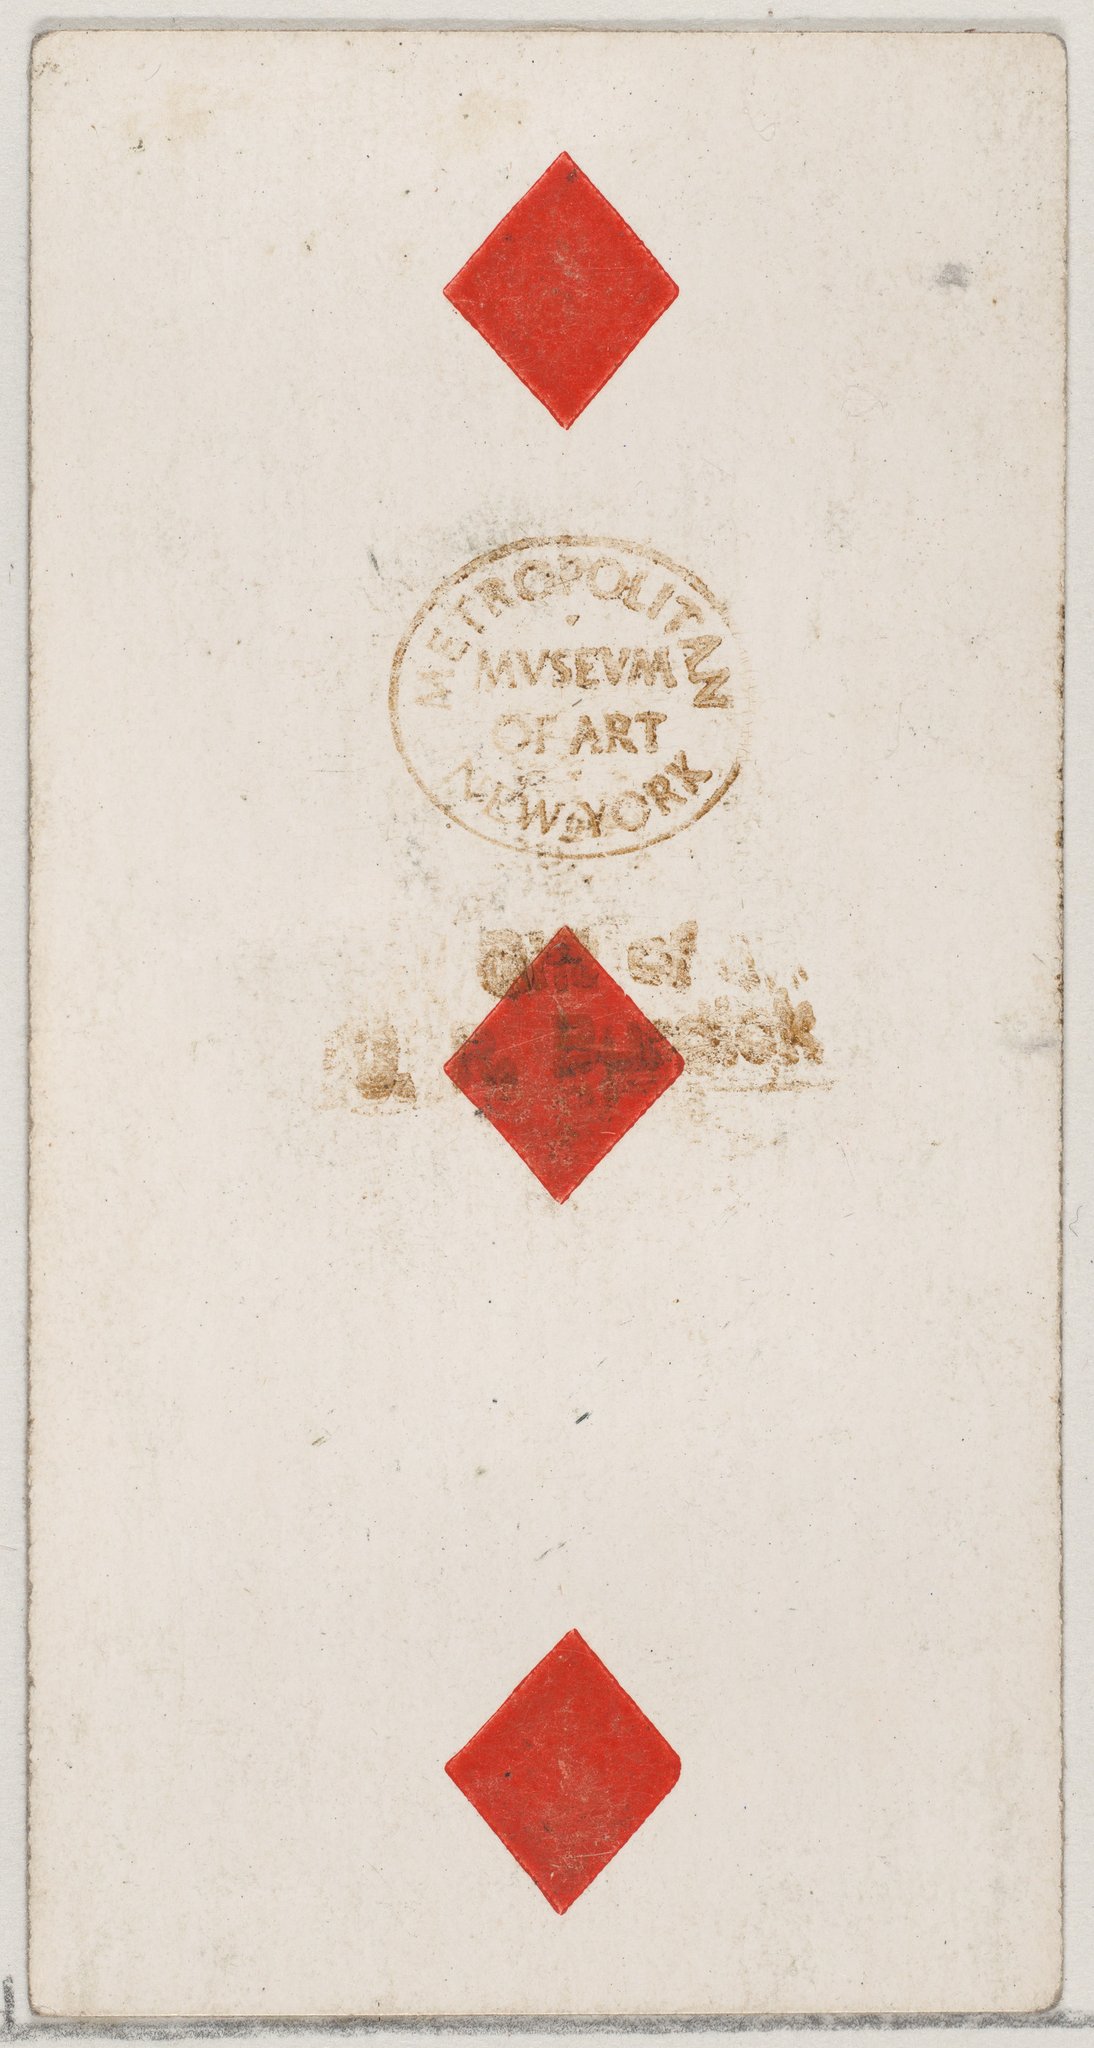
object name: print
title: Three Diamonds, from the Playing Cards series (N84) to promote Turkish Cross-Cut Cigarettes for W. Duke, Sons and Co.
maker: w. duke, sons & co.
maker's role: publisher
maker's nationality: american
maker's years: 1870-1920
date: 1888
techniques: color lithograph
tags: playing cards